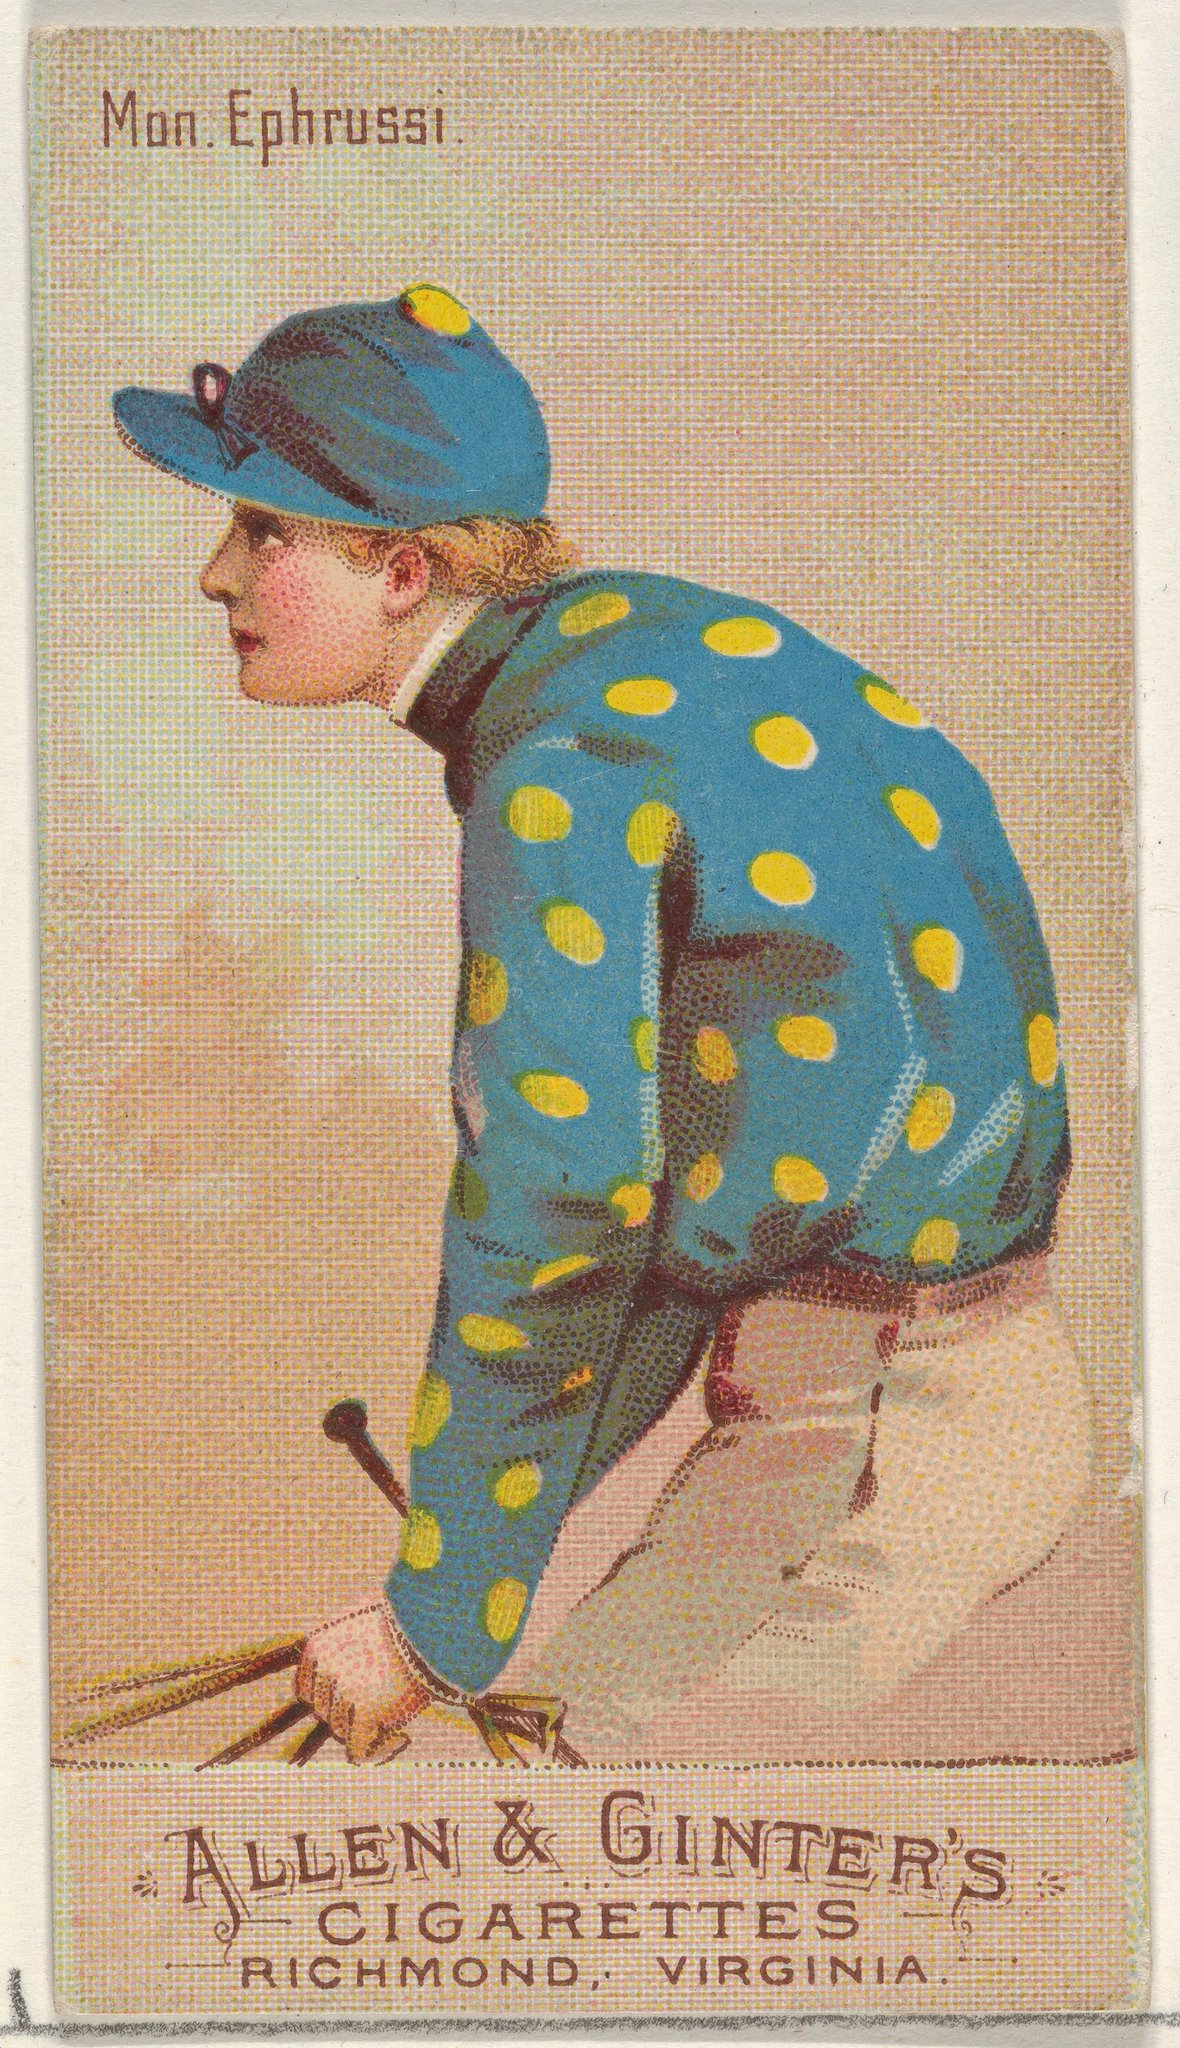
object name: print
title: Mon. Ephrussi, from the Racing Colors of the World series (N22b) for Allen & Ginter Cigarettes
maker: allen & ginter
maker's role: publisher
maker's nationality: american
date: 1888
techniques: color lithograph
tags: profiles,women,jockeys